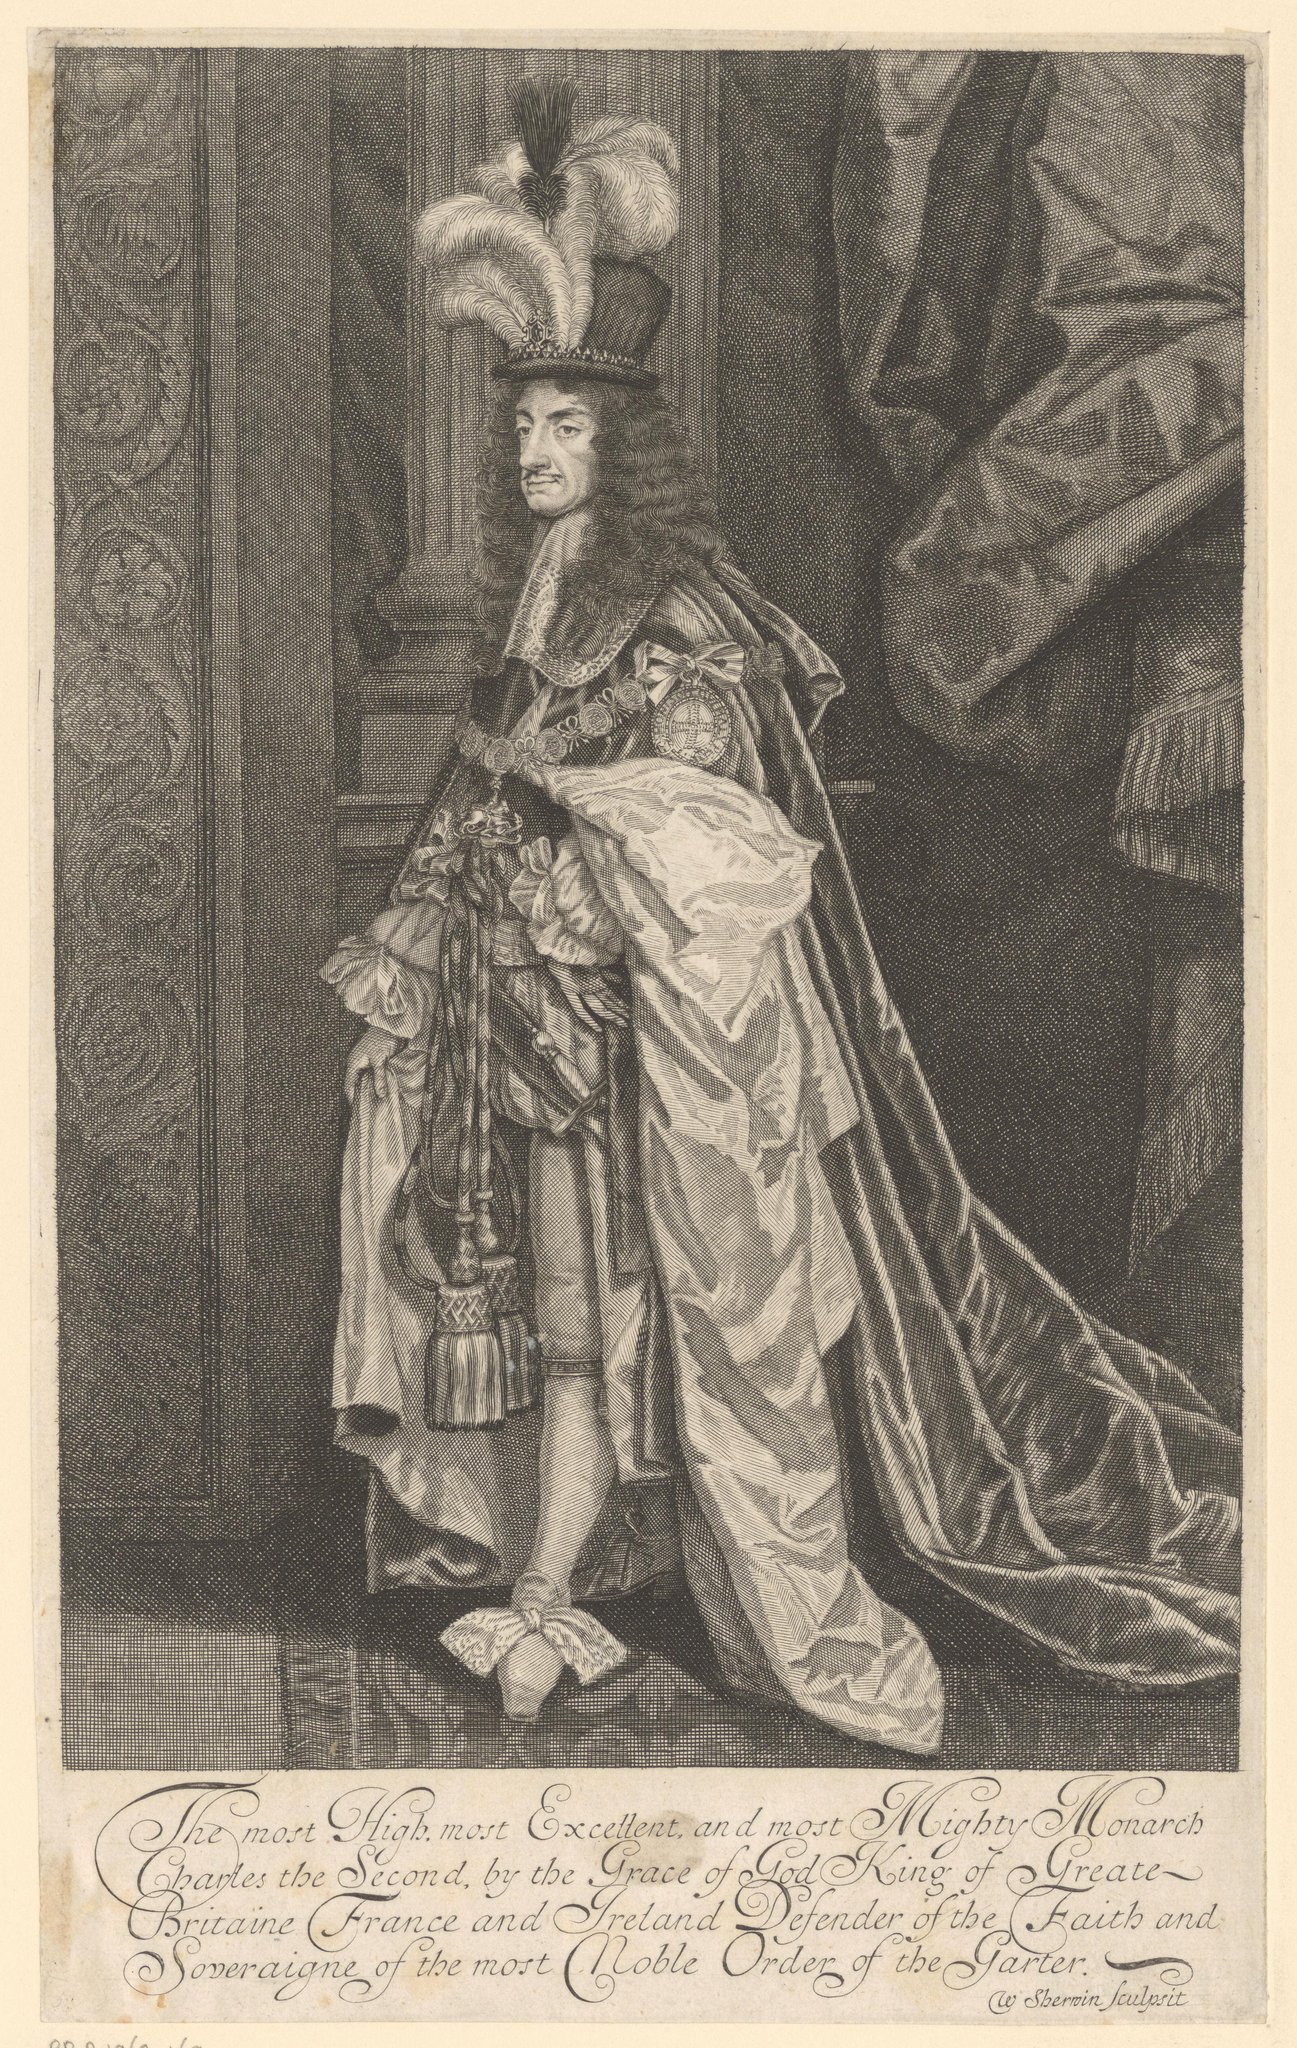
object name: book illustration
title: The most High, most Excellent, and most Mighty Monarch Charles the Second (...)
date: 1672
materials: paper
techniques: engraving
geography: great britain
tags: karel ii (koning van engeland), historical persons, king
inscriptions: collector's mark: Lugt 2228, collector's mark: Lugt 2760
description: Prent uit: Ashmole, Elias. The Institution, Laws & Ceremonies of the most Noble Order of the Garter. Londen: Nathanael Brooke, 1672.